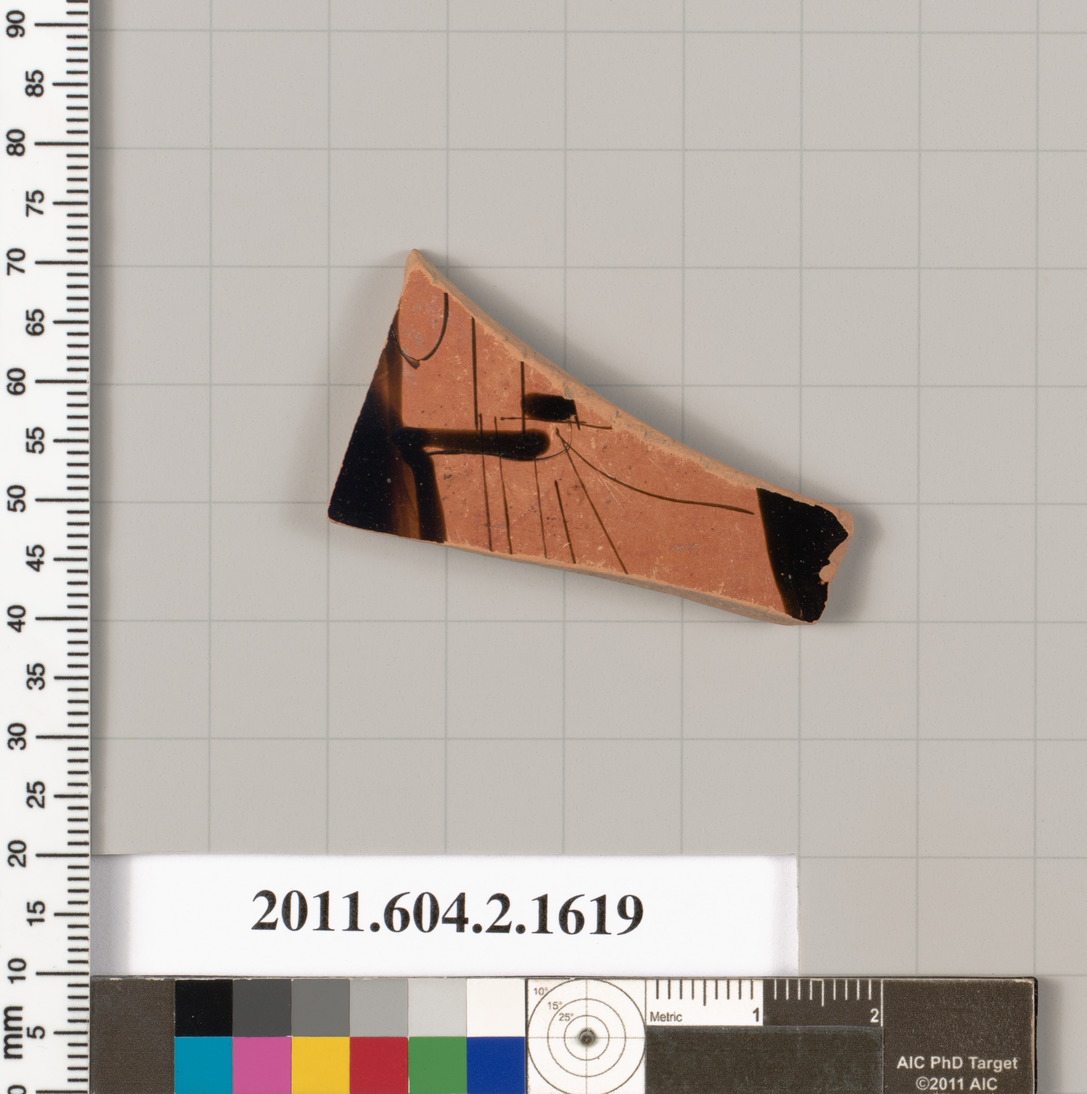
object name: skyphos fragment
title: Terracotta fragment of a skyphos (deep drinking cup)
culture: greek, attic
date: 467-435 BCE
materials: terracotta